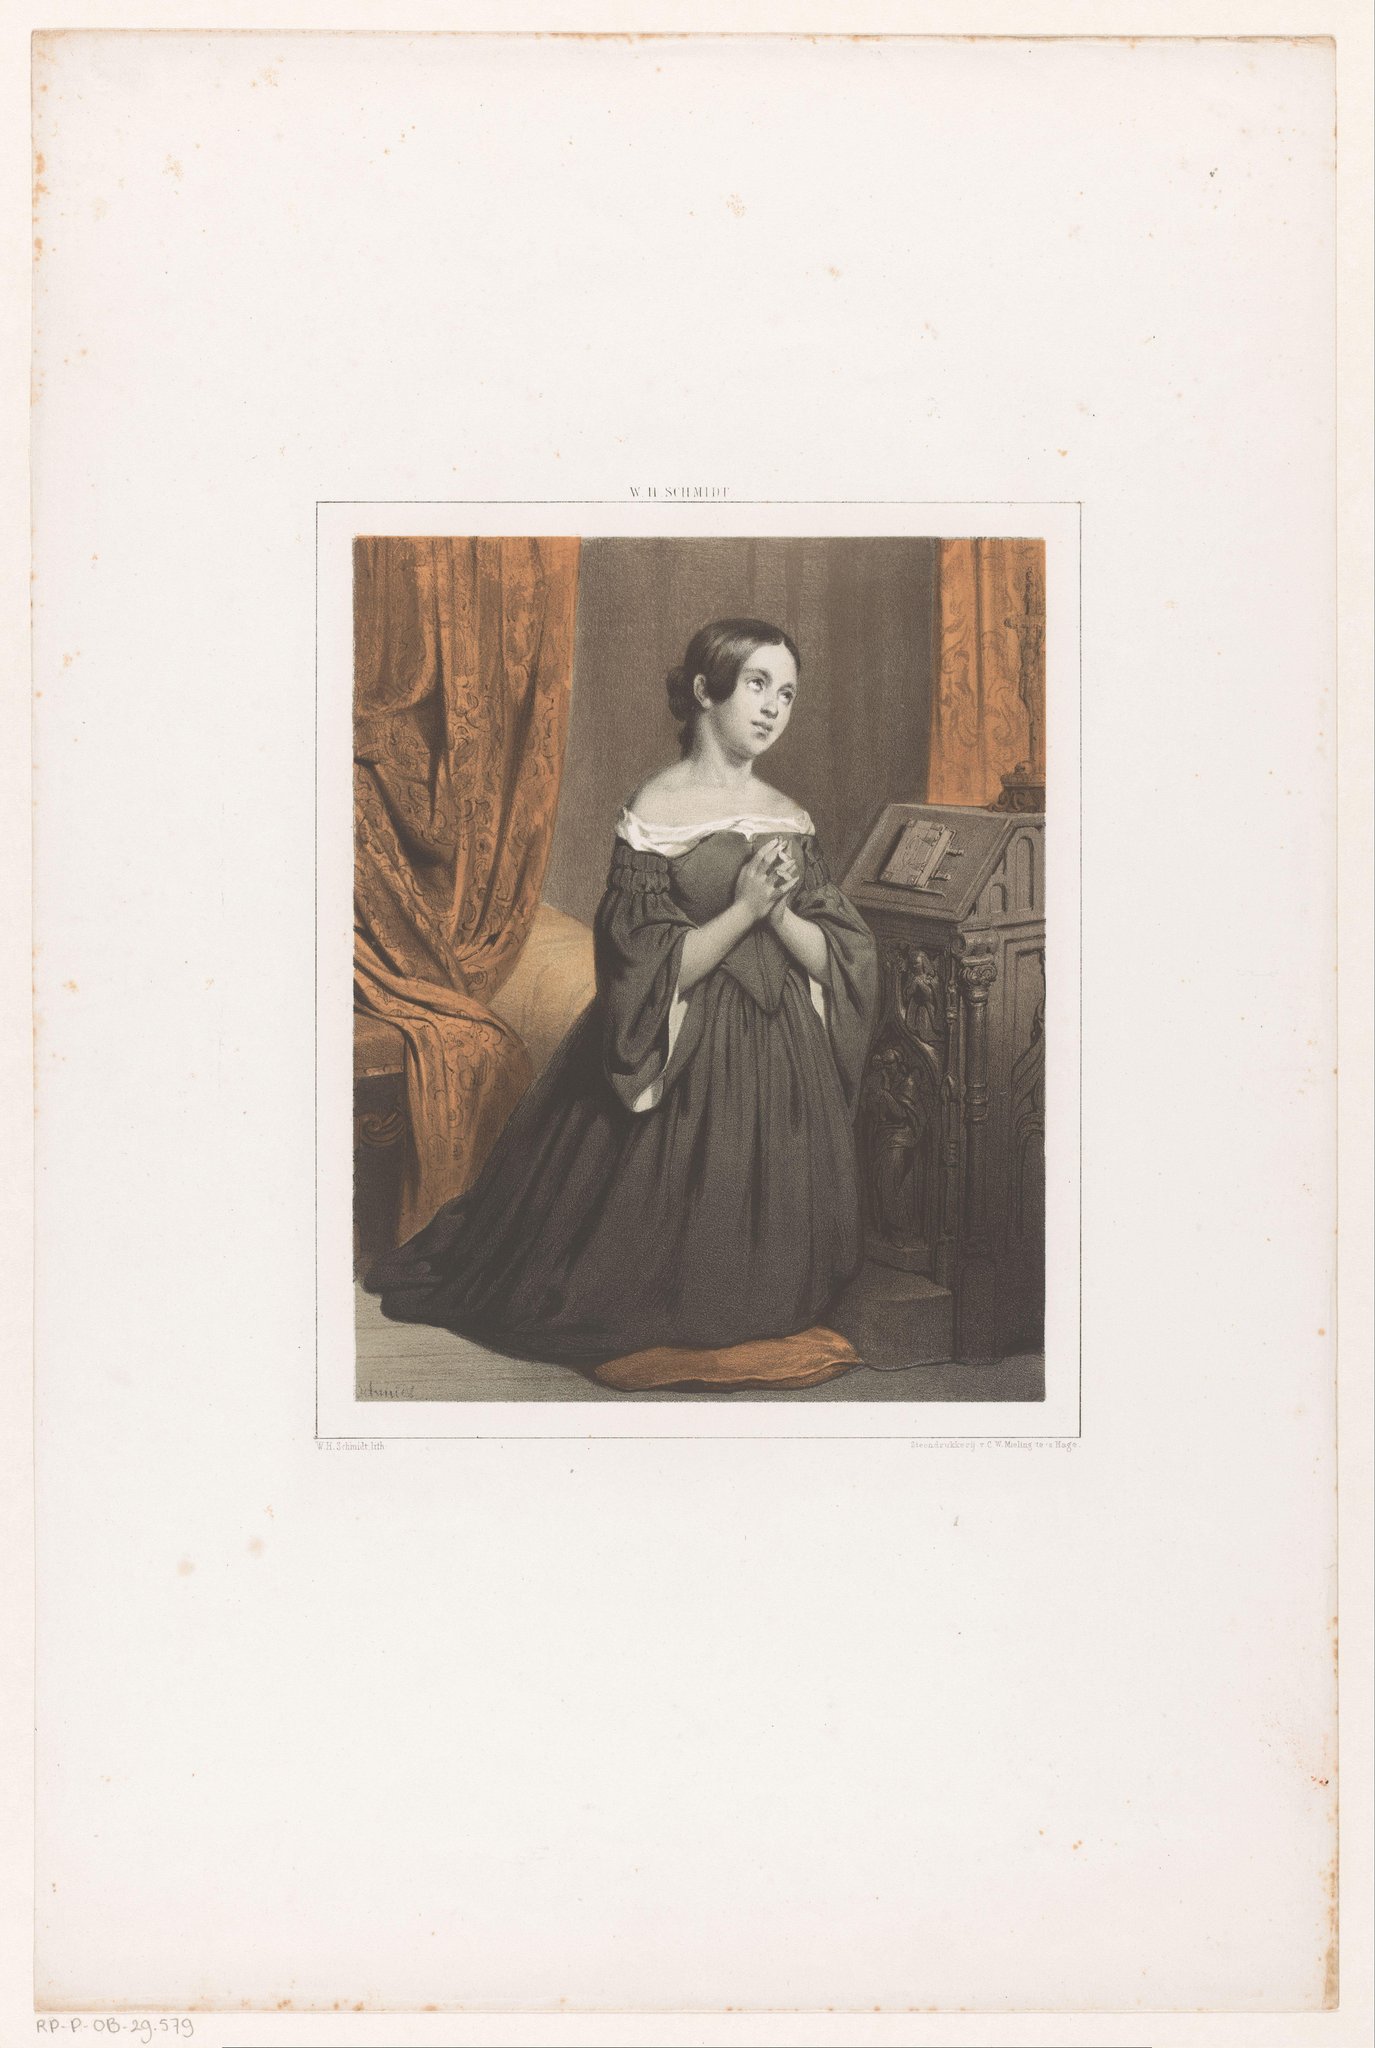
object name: print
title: Knielende vrouw in gebed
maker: willem hendrik schmidt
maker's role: draughtsman, painter, print maker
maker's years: 1809-1849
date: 1847-1849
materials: paper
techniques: tone lithography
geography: the hague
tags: one person praying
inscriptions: collector's mark: Lugt 2228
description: Een jonge vrouw knielend voor een preekstoel waarop een gebedenboek ligt.